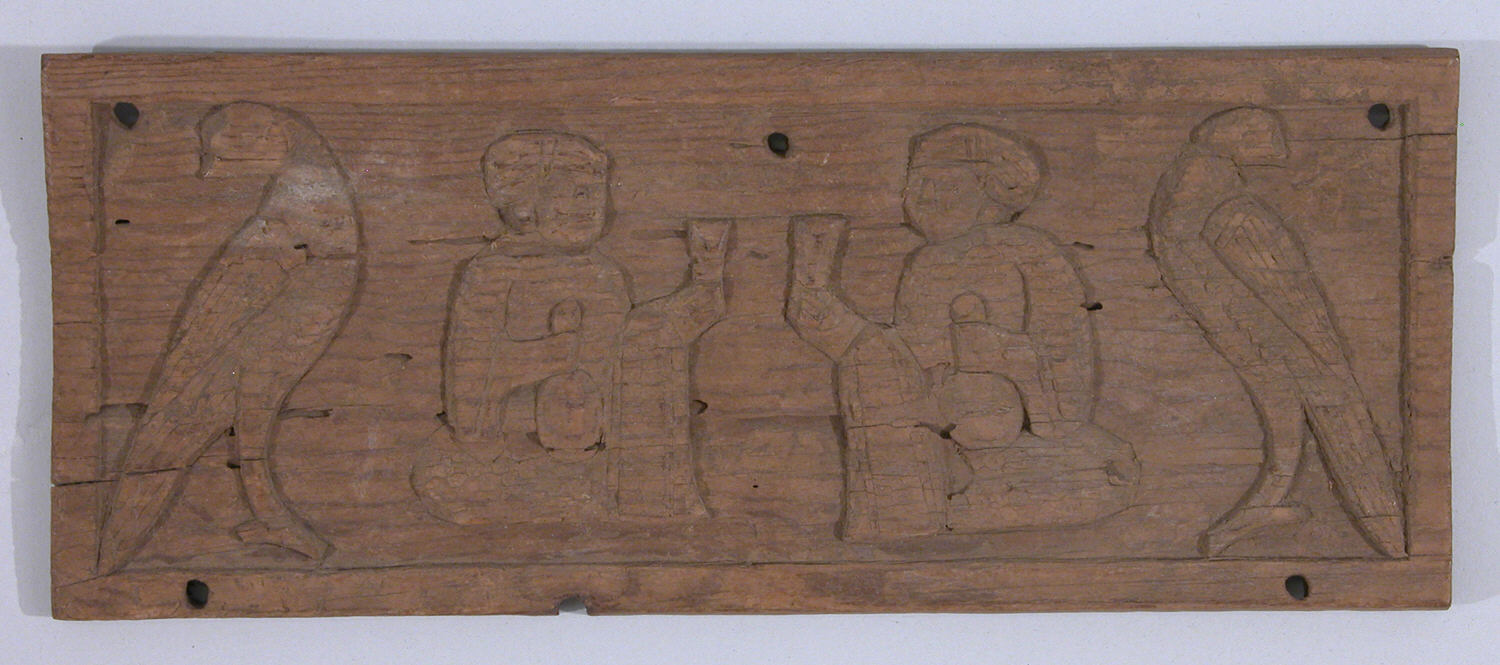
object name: panel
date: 1001-1100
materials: wood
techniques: carving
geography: egypt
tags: human figures,birds,drinking